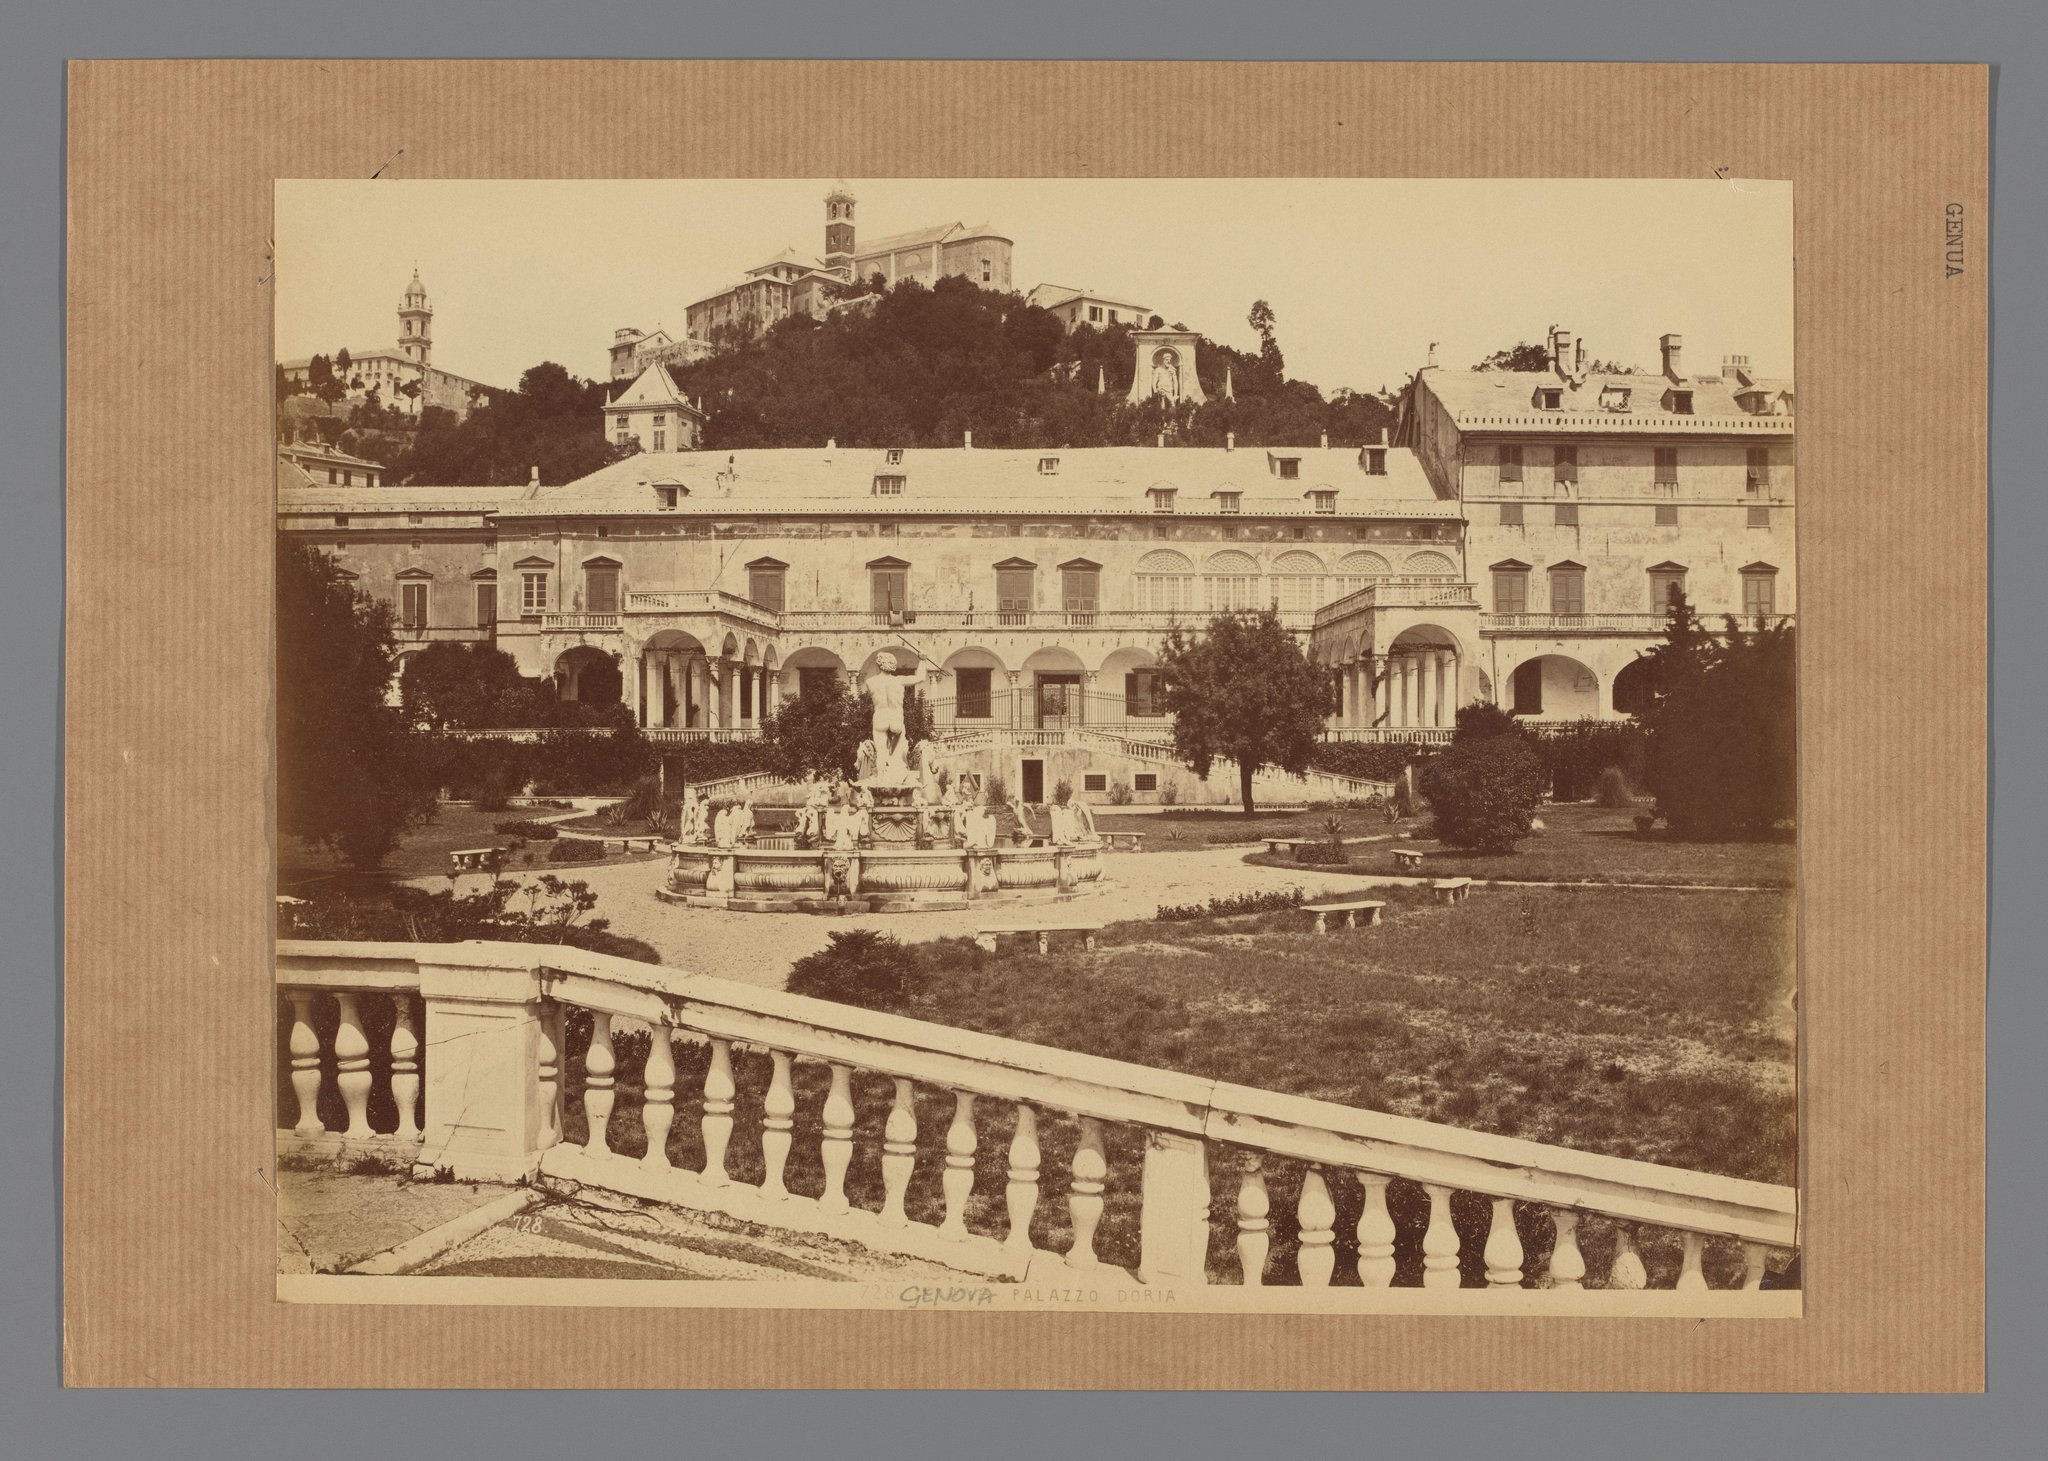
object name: photograph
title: Italië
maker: Anonymous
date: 1880-1910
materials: photographic support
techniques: albumen print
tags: italy